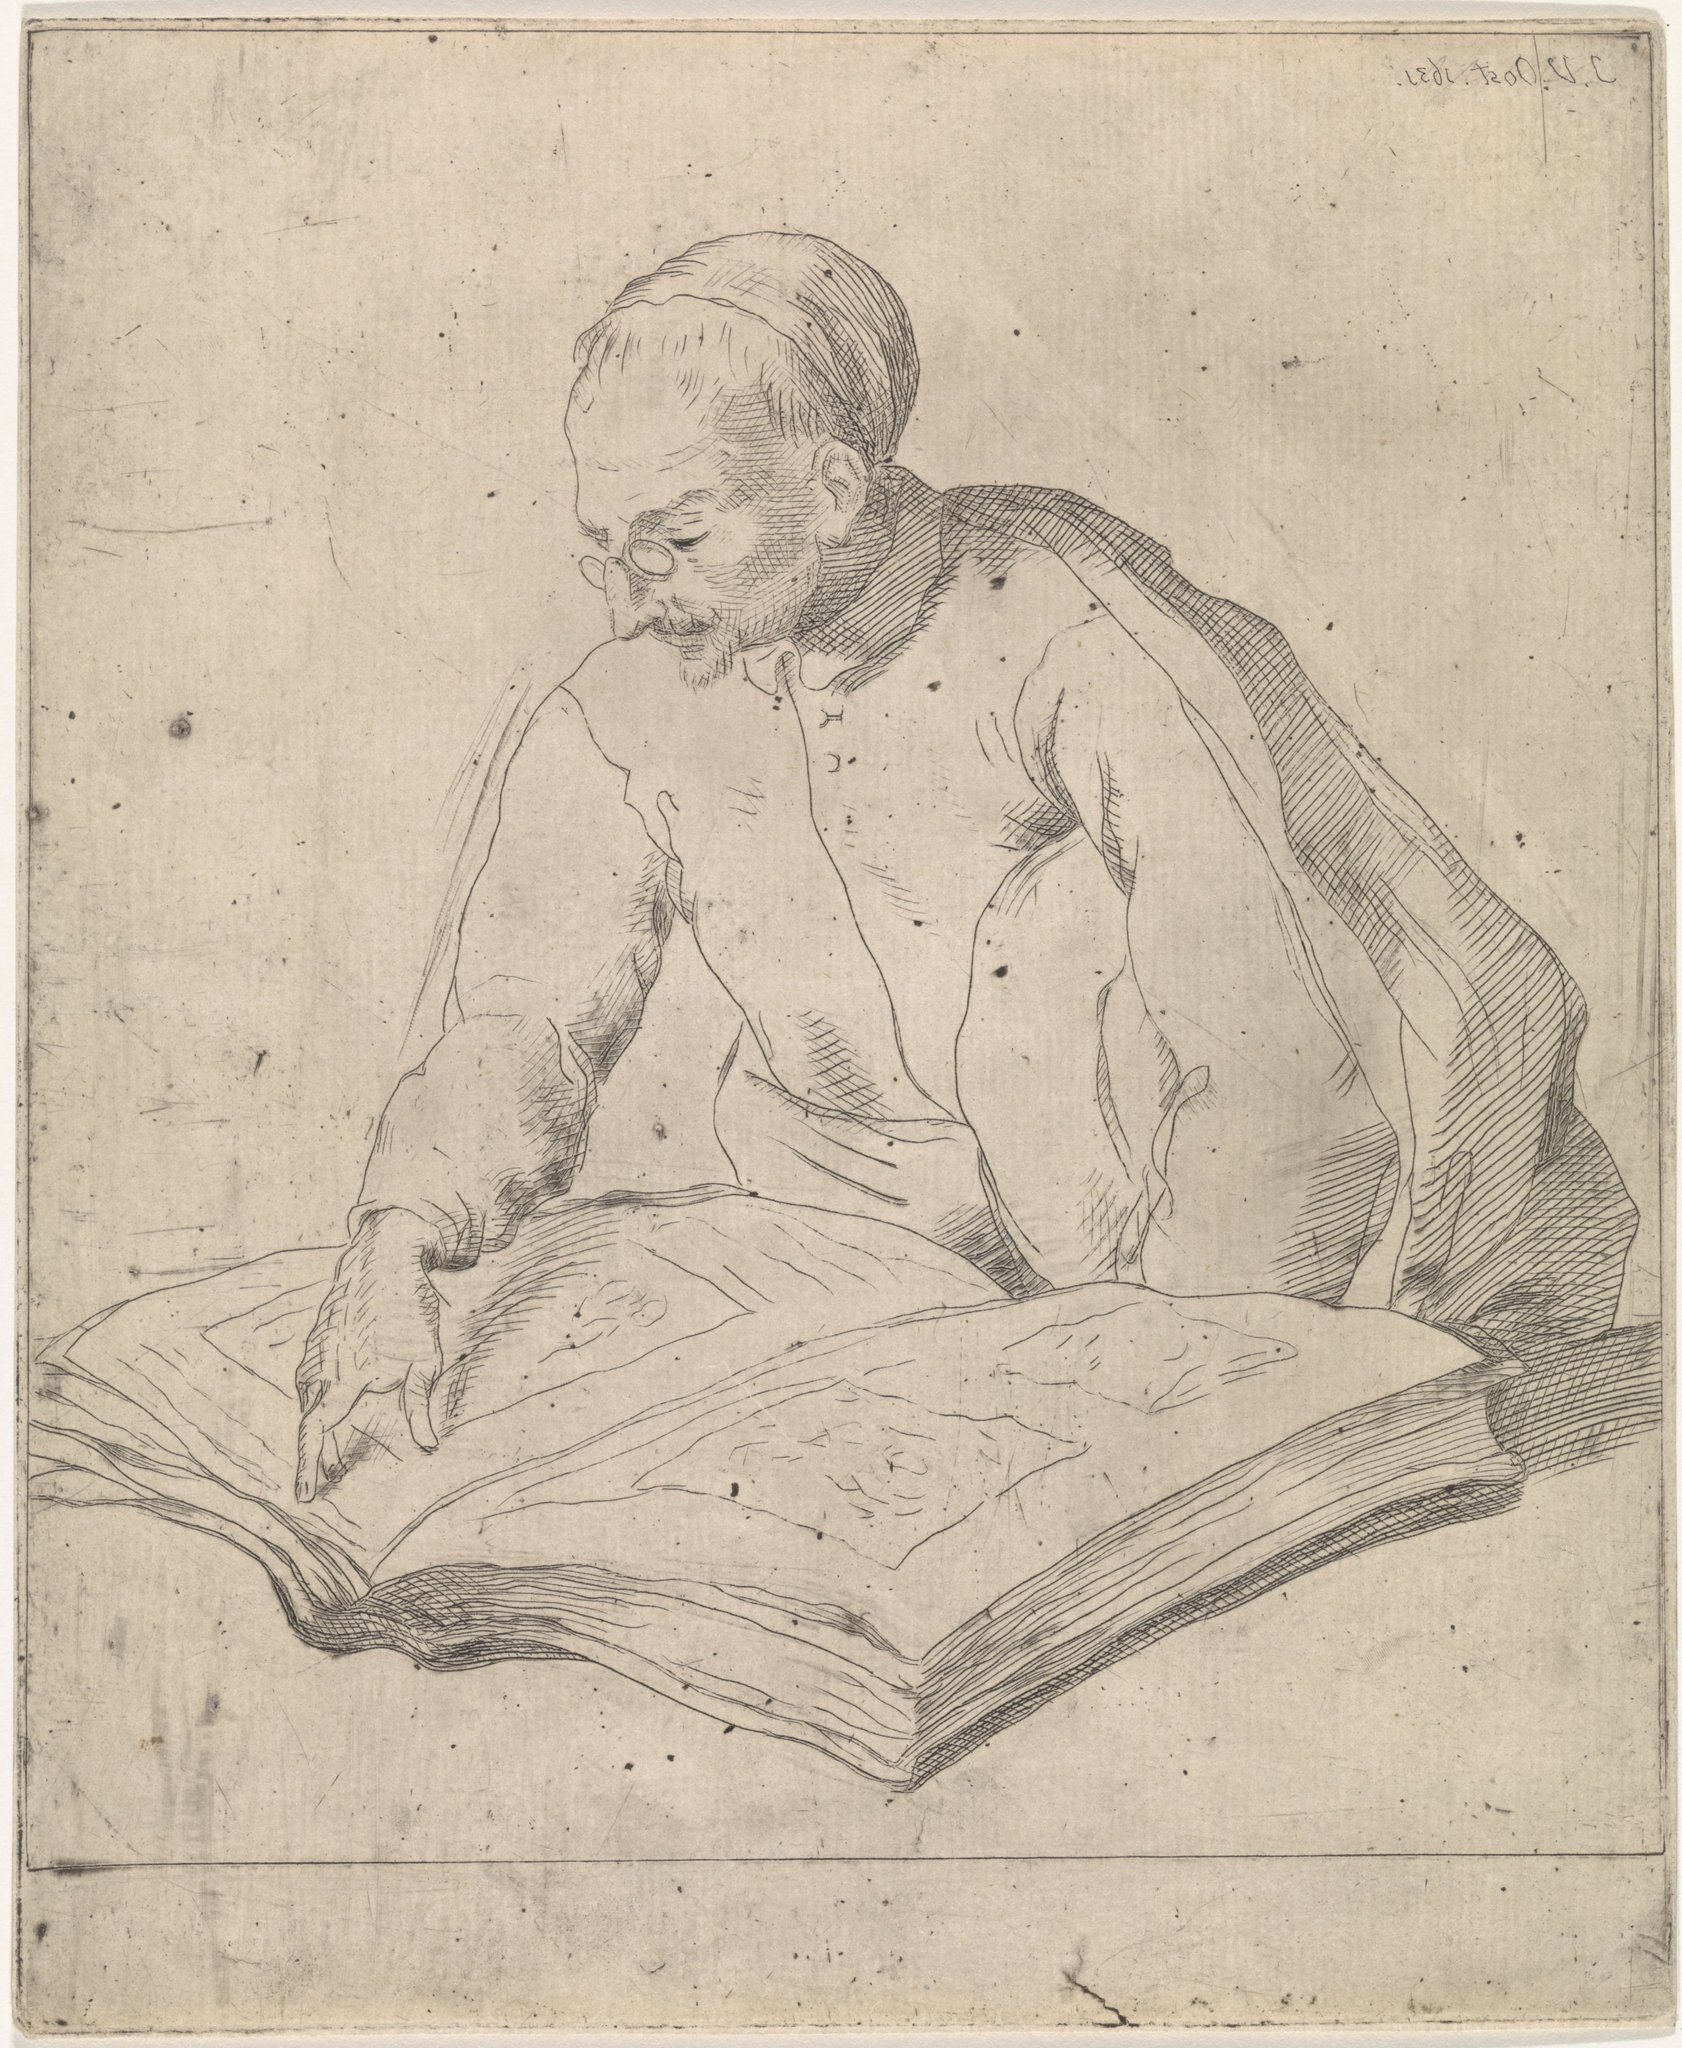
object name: print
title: Portret van de verzamelaar Sebastiano Resta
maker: jacob van oost (i)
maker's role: painter, print maker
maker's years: 1603-1671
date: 1631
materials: paper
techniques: etching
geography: southern netherlands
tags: eyeglasses, spectacles, art collector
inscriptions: collector's mark: Lugt 2228, collector's mark: ‘IB.’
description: Prent naar de tekening van Carlo Marrati in de Devonshire collection. Deze tekening is echter gedateerd 1689.